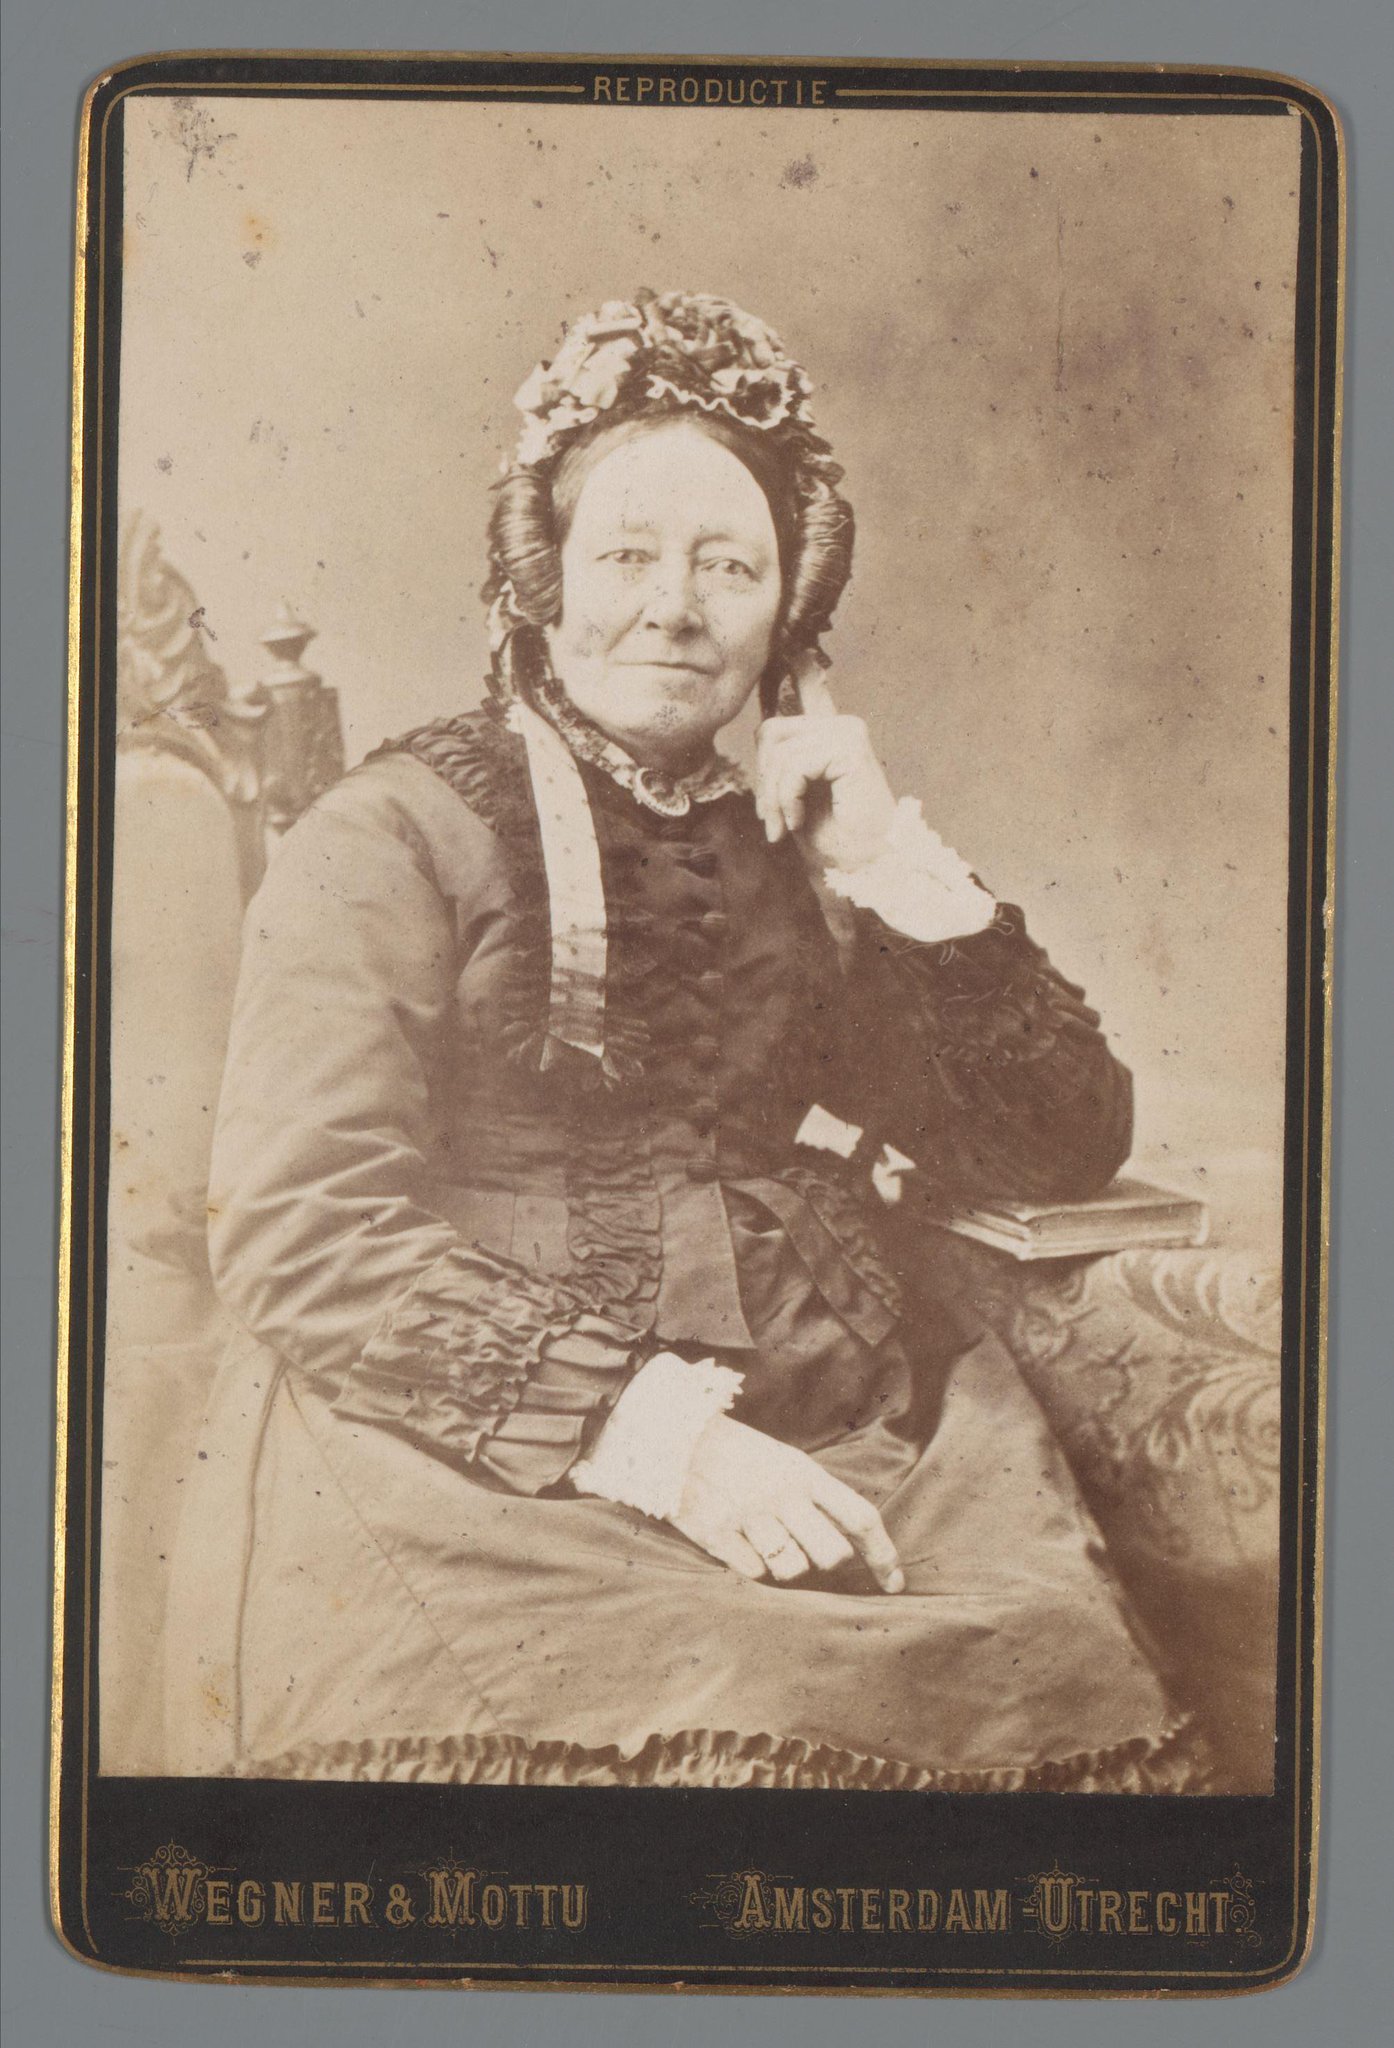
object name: photograph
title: Portret van Maria Engelina Jonker van Zijp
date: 1877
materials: cardboard, photographic support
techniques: albumen print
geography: amsterdam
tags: historical persons, amsterdam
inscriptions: annotation: ‘Mevrouw Jonker van Zijp/ overl. ± 1884’, workshop stamp: ‘Photographisch Artistisch Atelier/ van Wegner & Mottu/ Amsterdam, Rokin over de Bank, 138/ Utrecht, Hamburgerstraat, F 237’